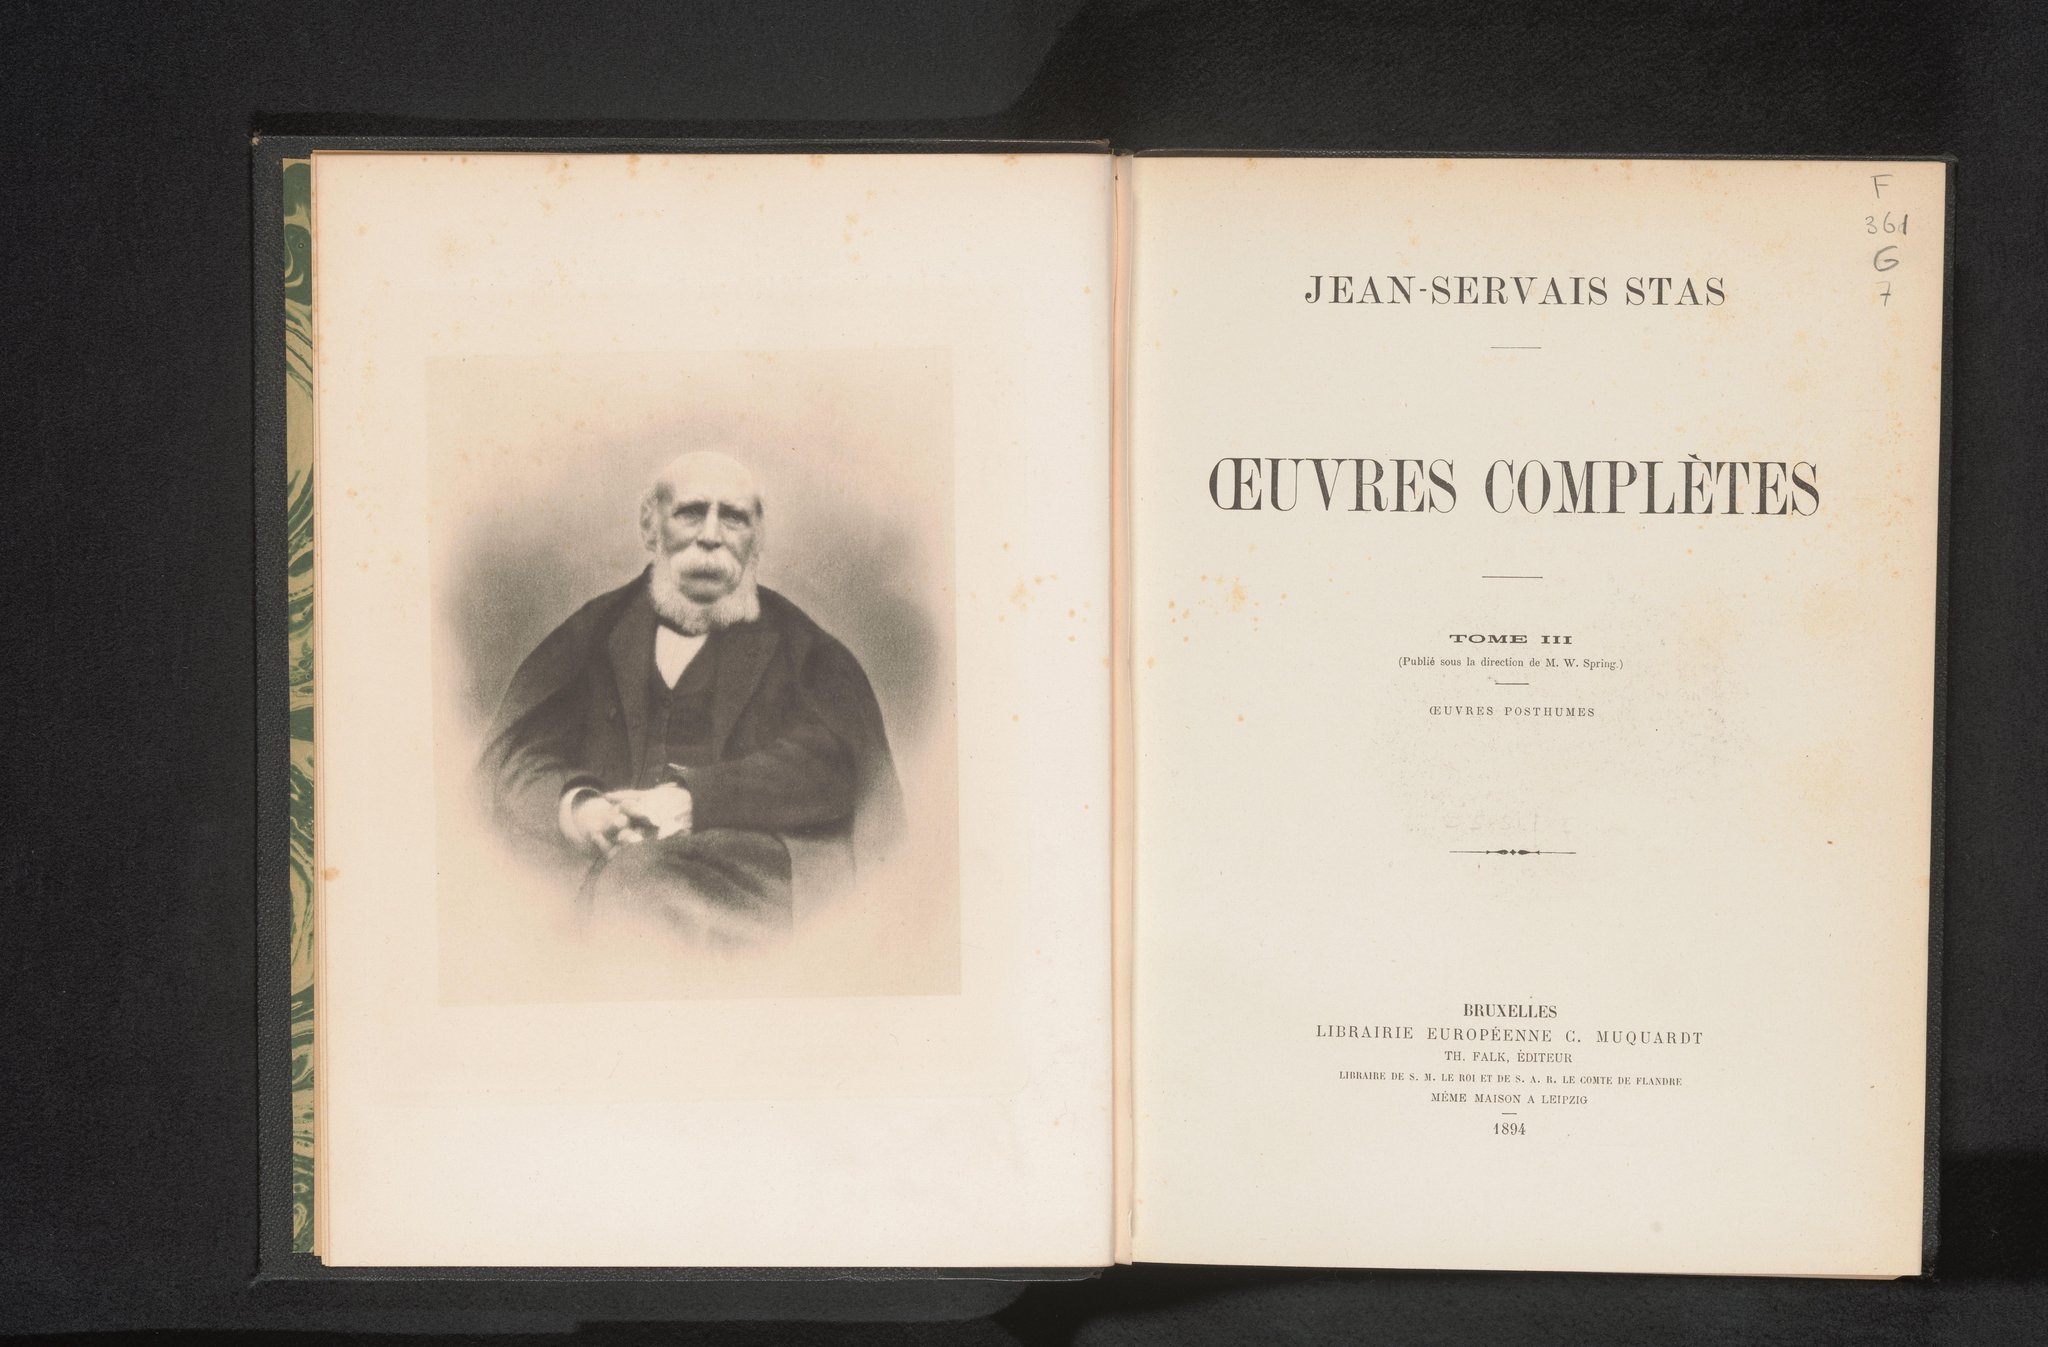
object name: book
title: Oeuvres complètes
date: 1894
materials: linen, paper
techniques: decorated paper, photoaquatint, printing, engraving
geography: brussels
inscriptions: date: ‘Dec 1990’